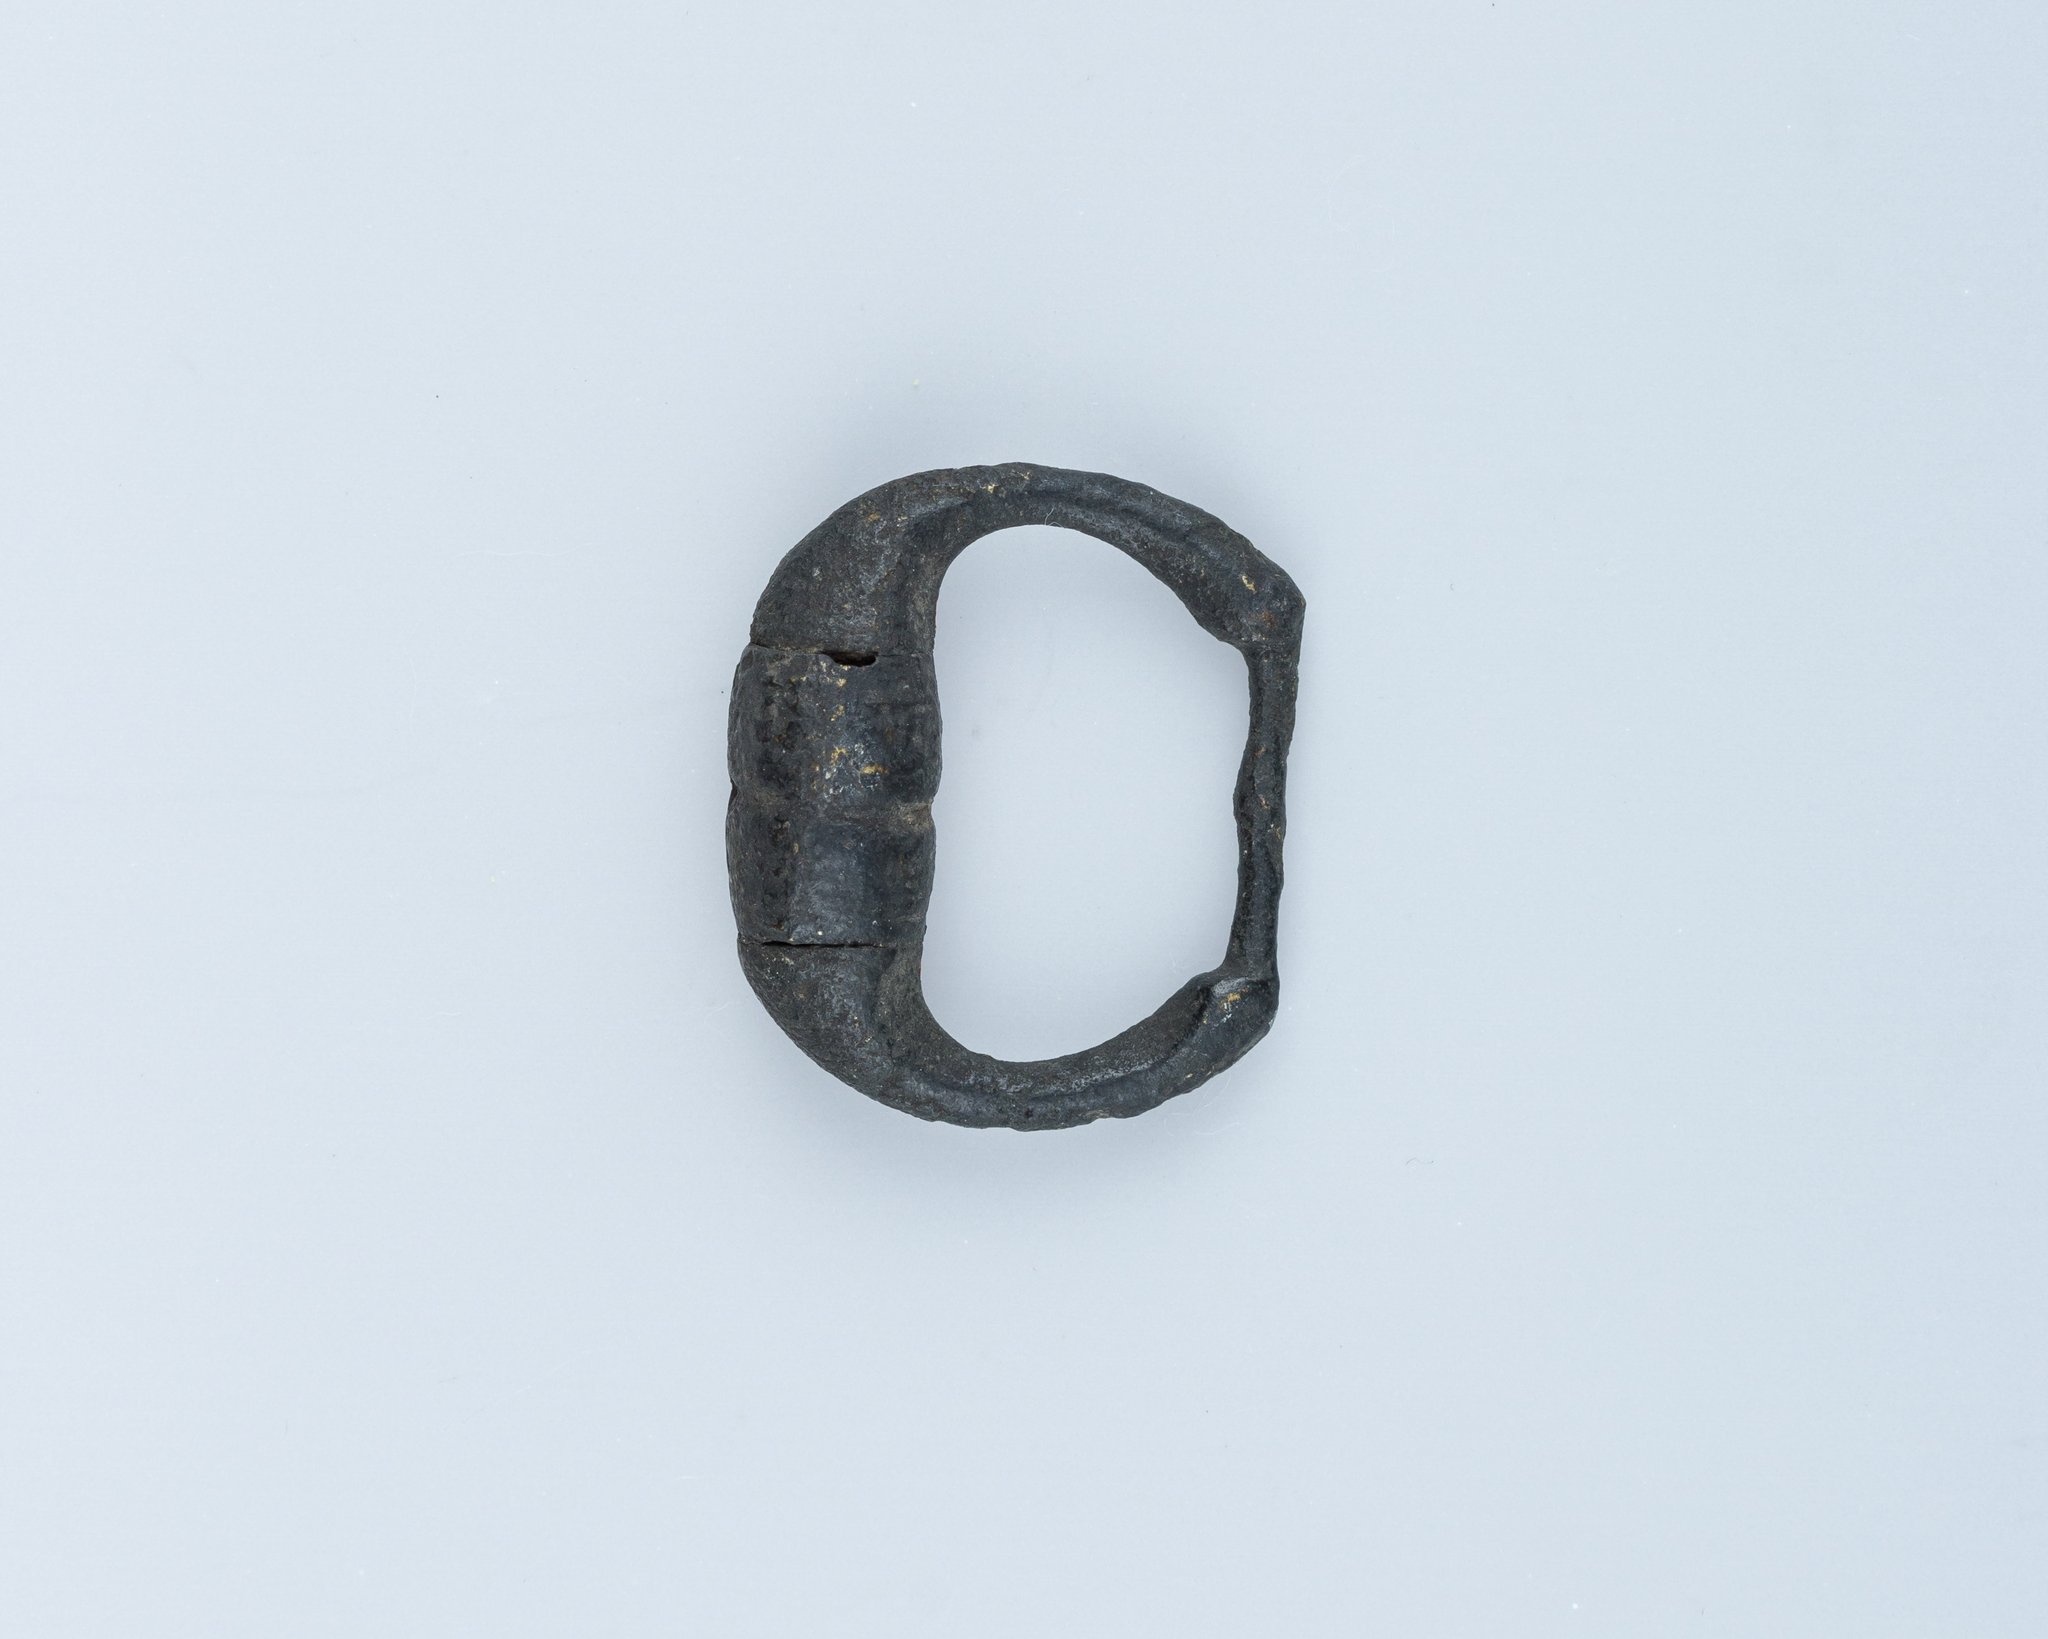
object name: buckle loop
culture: french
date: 401-500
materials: bronze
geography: france